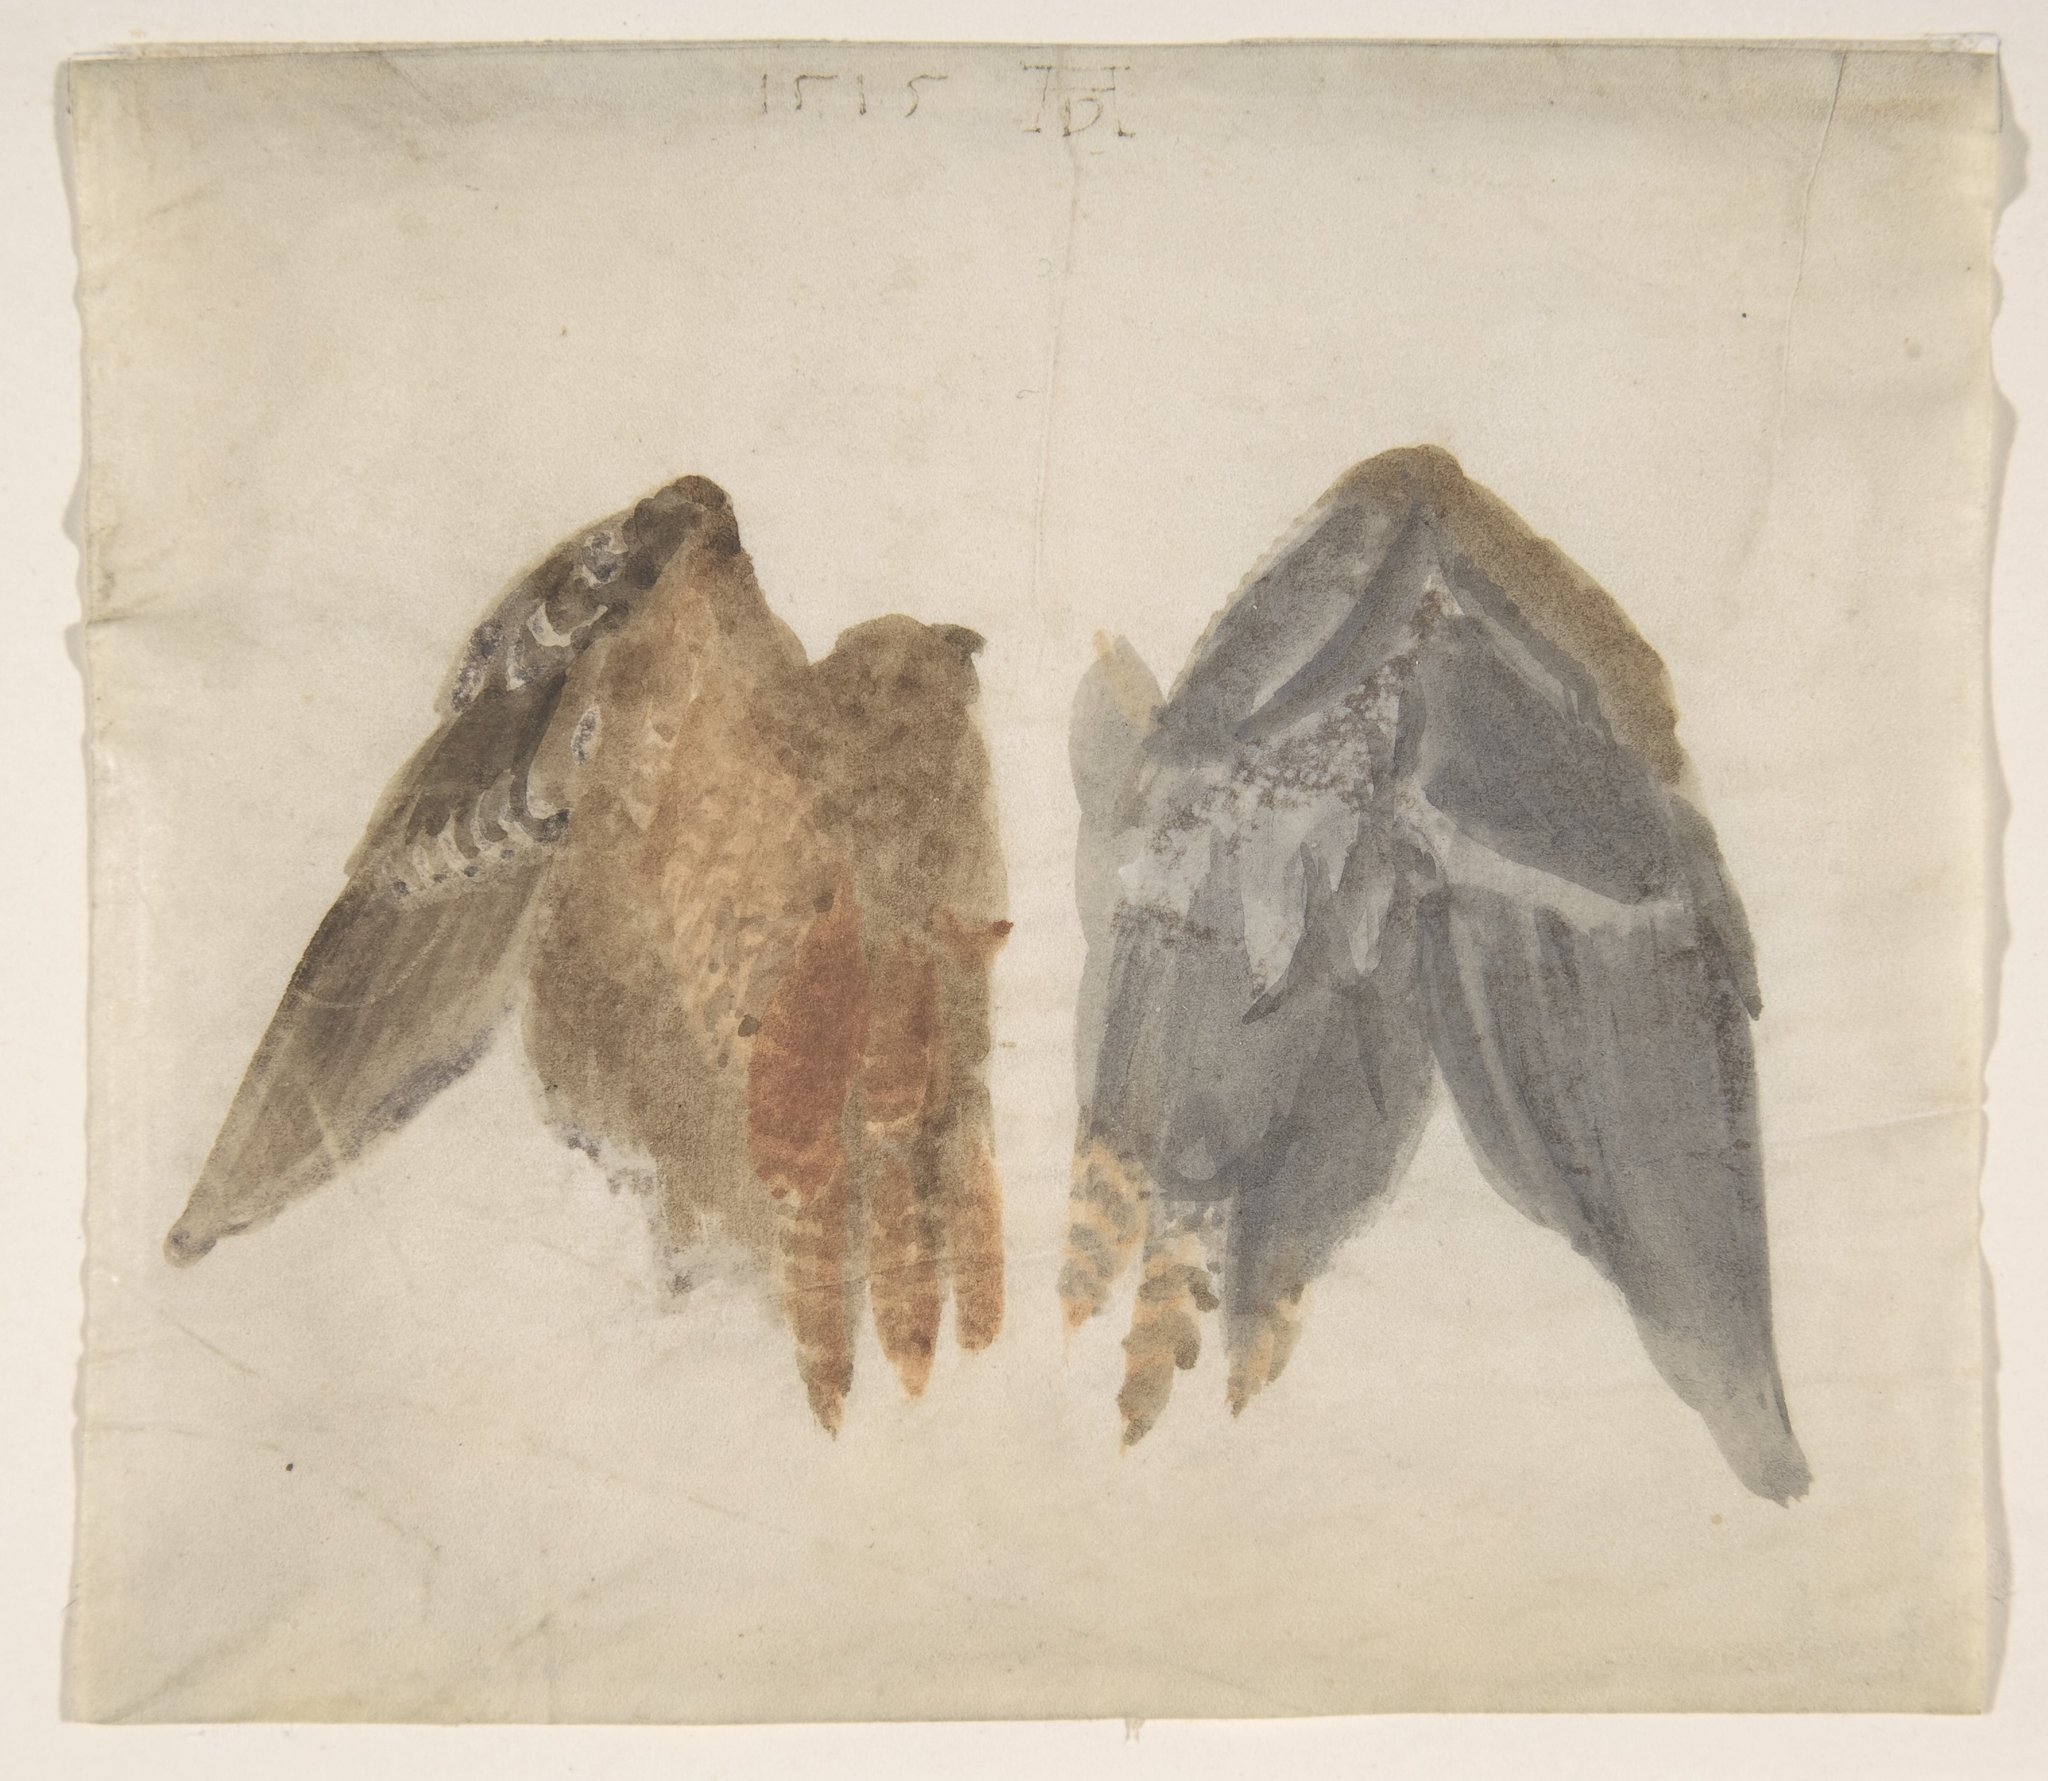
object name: drawing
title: Bittern's Wings: study showing both sides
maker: albrecht dürer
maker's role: artist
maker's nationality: german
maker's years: 1471-1528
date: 1515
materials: parchment, watercolor